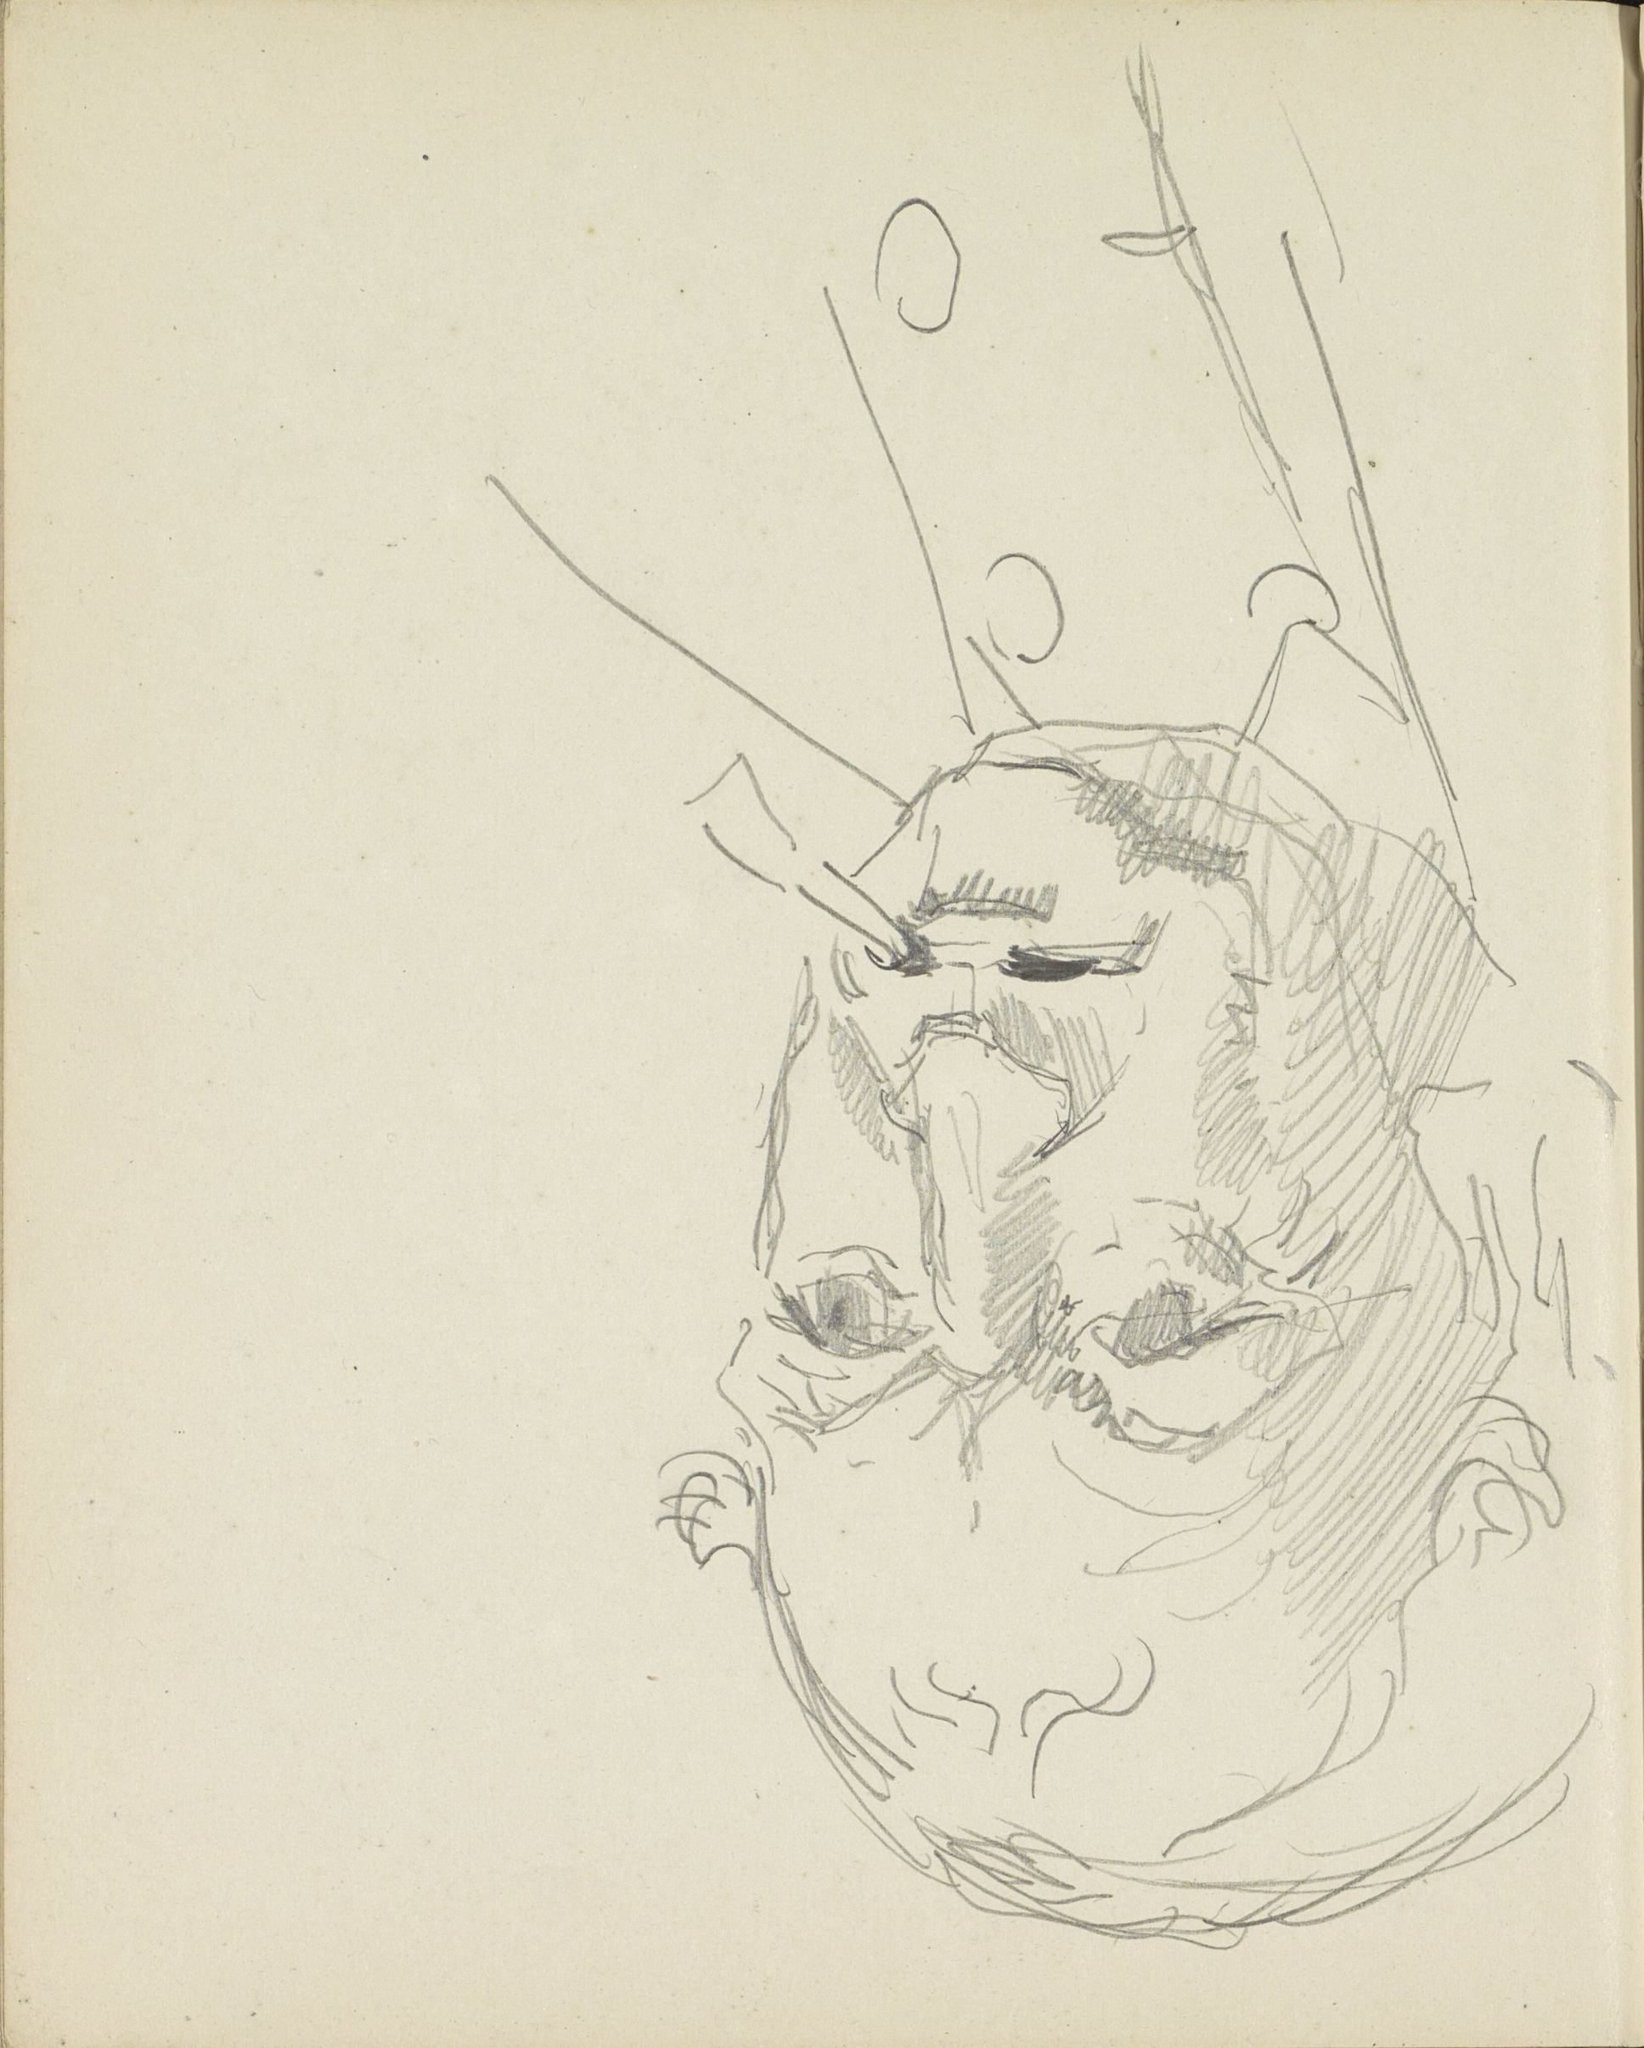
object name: sketchbook leaf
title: Portret van een man met een sigaret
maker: cornelis vreedenburgh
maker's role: draughtsman, print maker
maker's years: 1880-1946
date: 1890-1946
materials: paper, pencil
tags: head (human), cigarette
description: Blad 58 verso uit een schetsboek met 76 bladen.